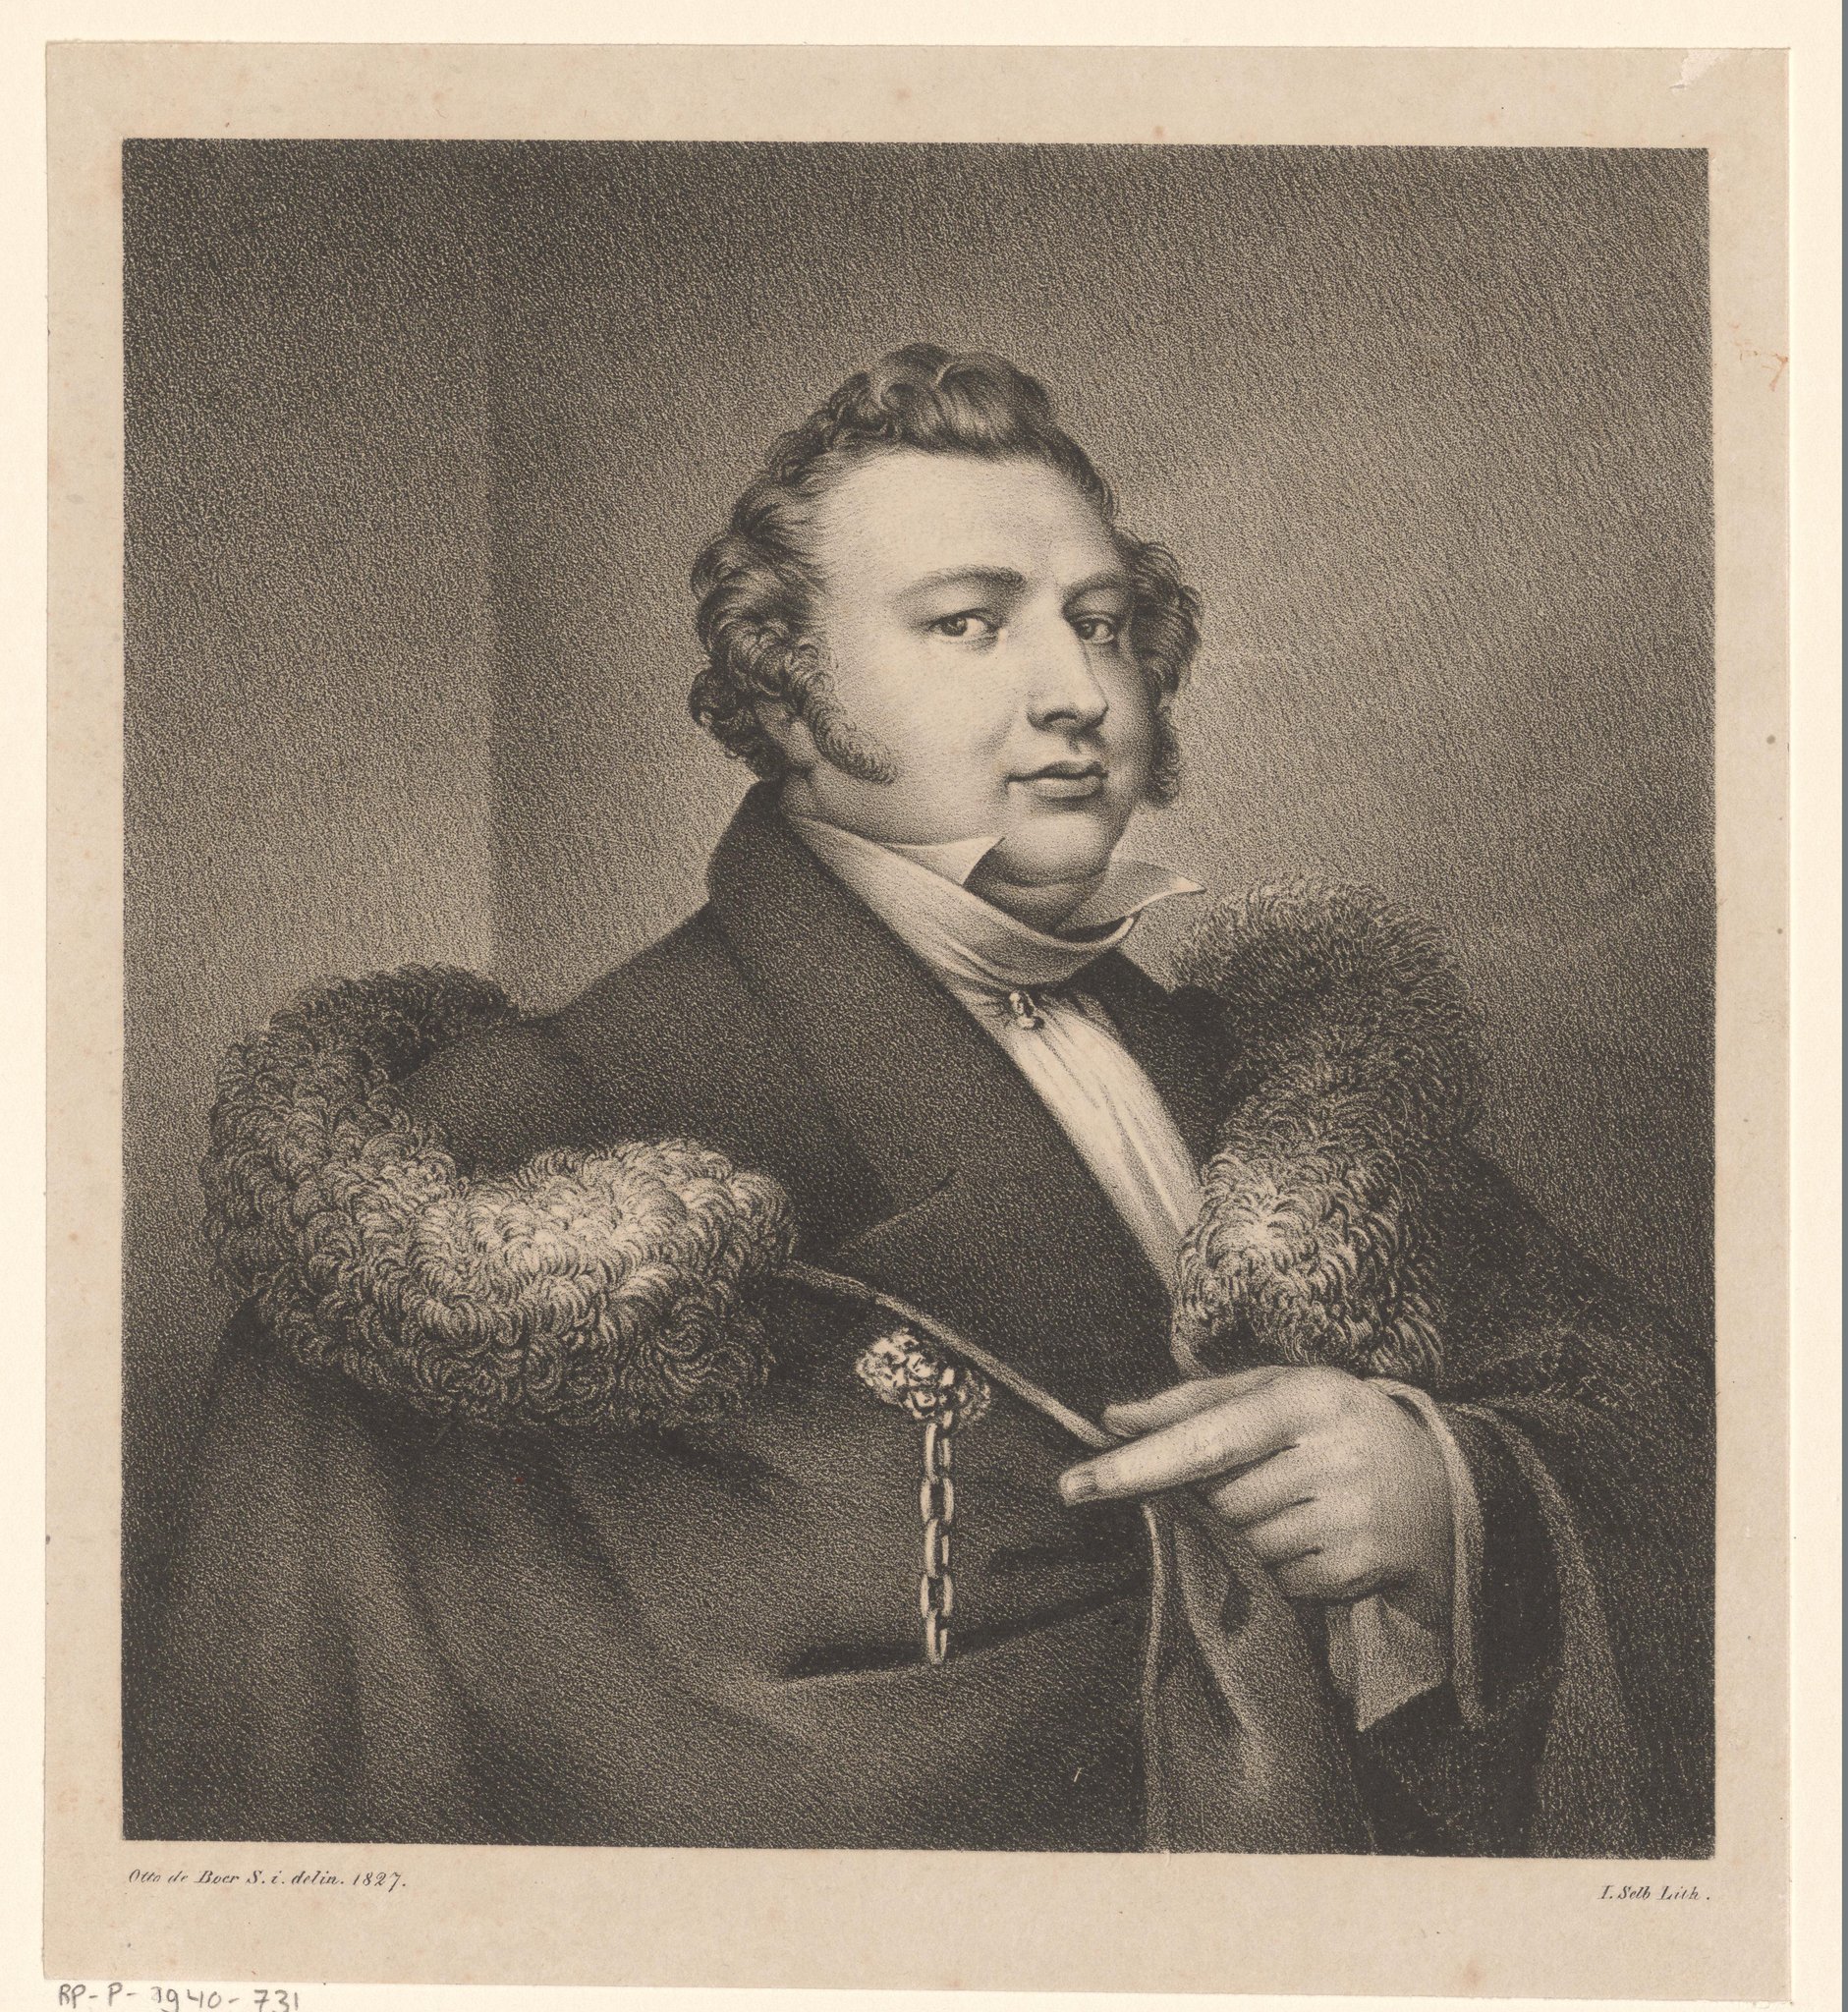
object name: print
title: Zelfportret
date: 1827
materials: paper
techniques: lithograph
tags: painter, draughtsman, otto de boer, historical persons, portrait, self-portrait of artist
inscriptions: collector's mark: Lugt 2228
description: Bijgevoegd op het opzetvet is een handtekening van Otto de Boer, mogelijk afkomstig uit een brief.